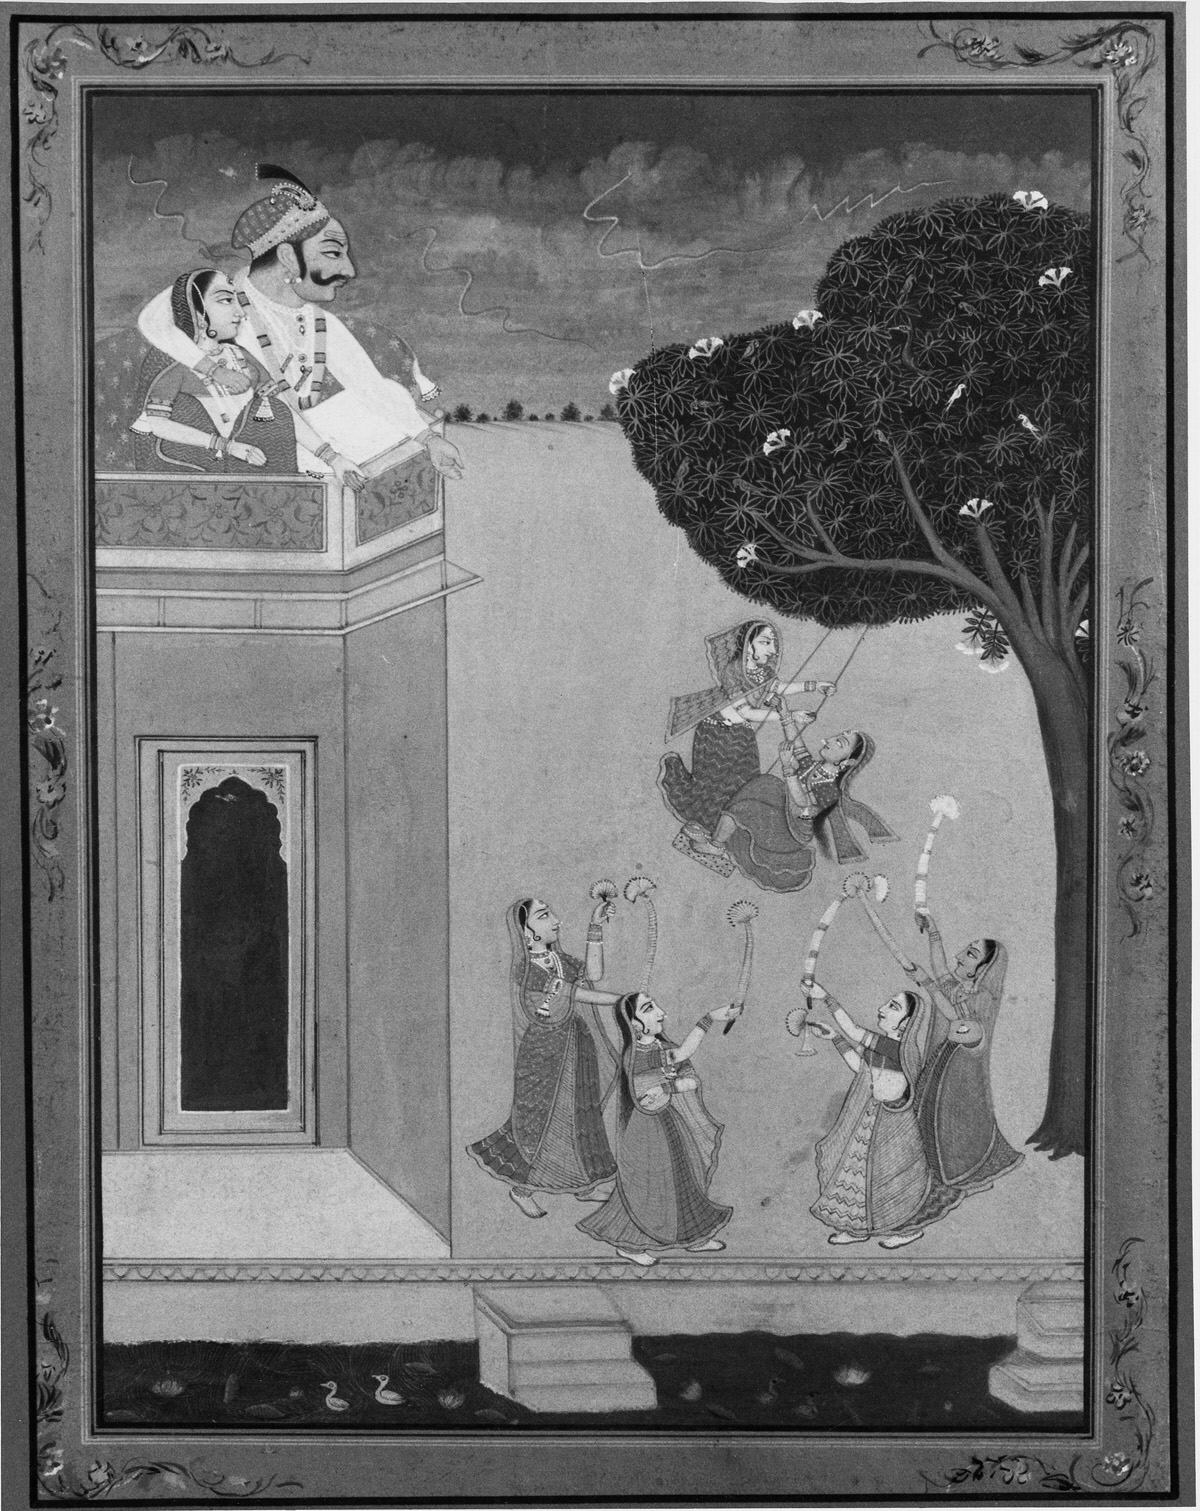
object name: leaf from a ragamala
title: Princely Couple on Balcony Watching Maidens on Swing and Dancers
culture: indian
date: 1800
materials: gold, paper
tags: balconies,men,women,dancers